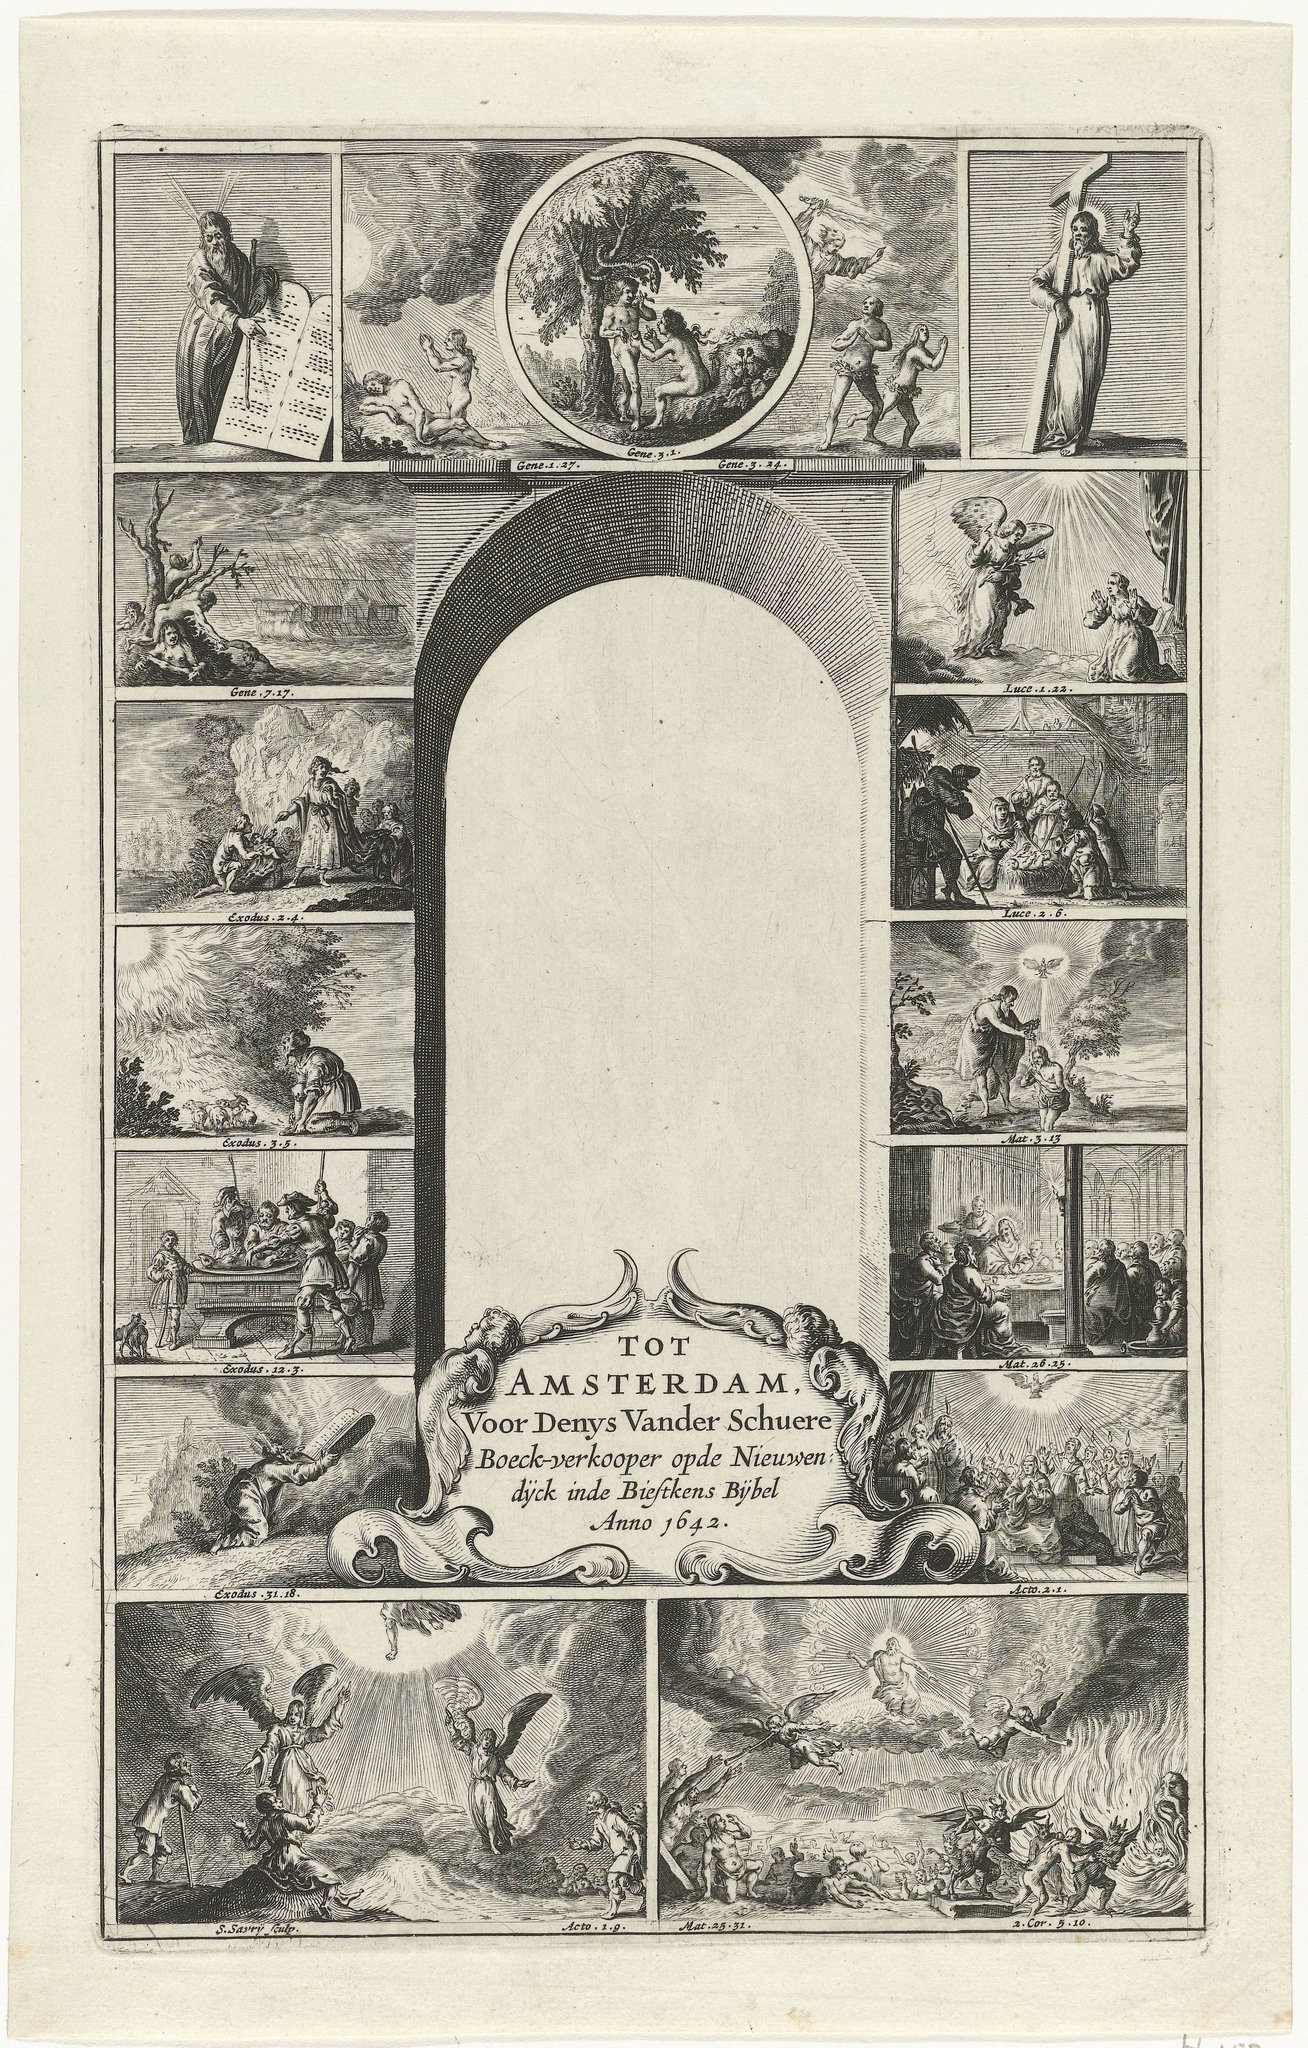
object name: print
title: Omlijsting met scènes uit het Oude en Nieuwe Testament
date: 1642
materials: paper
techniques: engraving, etching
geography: amsterdam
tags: old testament and new testament ~ christian doctrine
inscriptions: collector's mark: Lugt 2228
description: Proefdruk titelpagina voor: Biestkens van Diest, Nicolaes. Biblia dat is: De gantsche H. Schriftvre. Amsterdam: Denijs Verschuere, 1642. De titelpagina is gebruikt voor de heruitgave van de doopsgezinde Biestkens Bijbel, genoemd naar de oorspronkelijke drukker Nicolaas Bieskens te Emden.